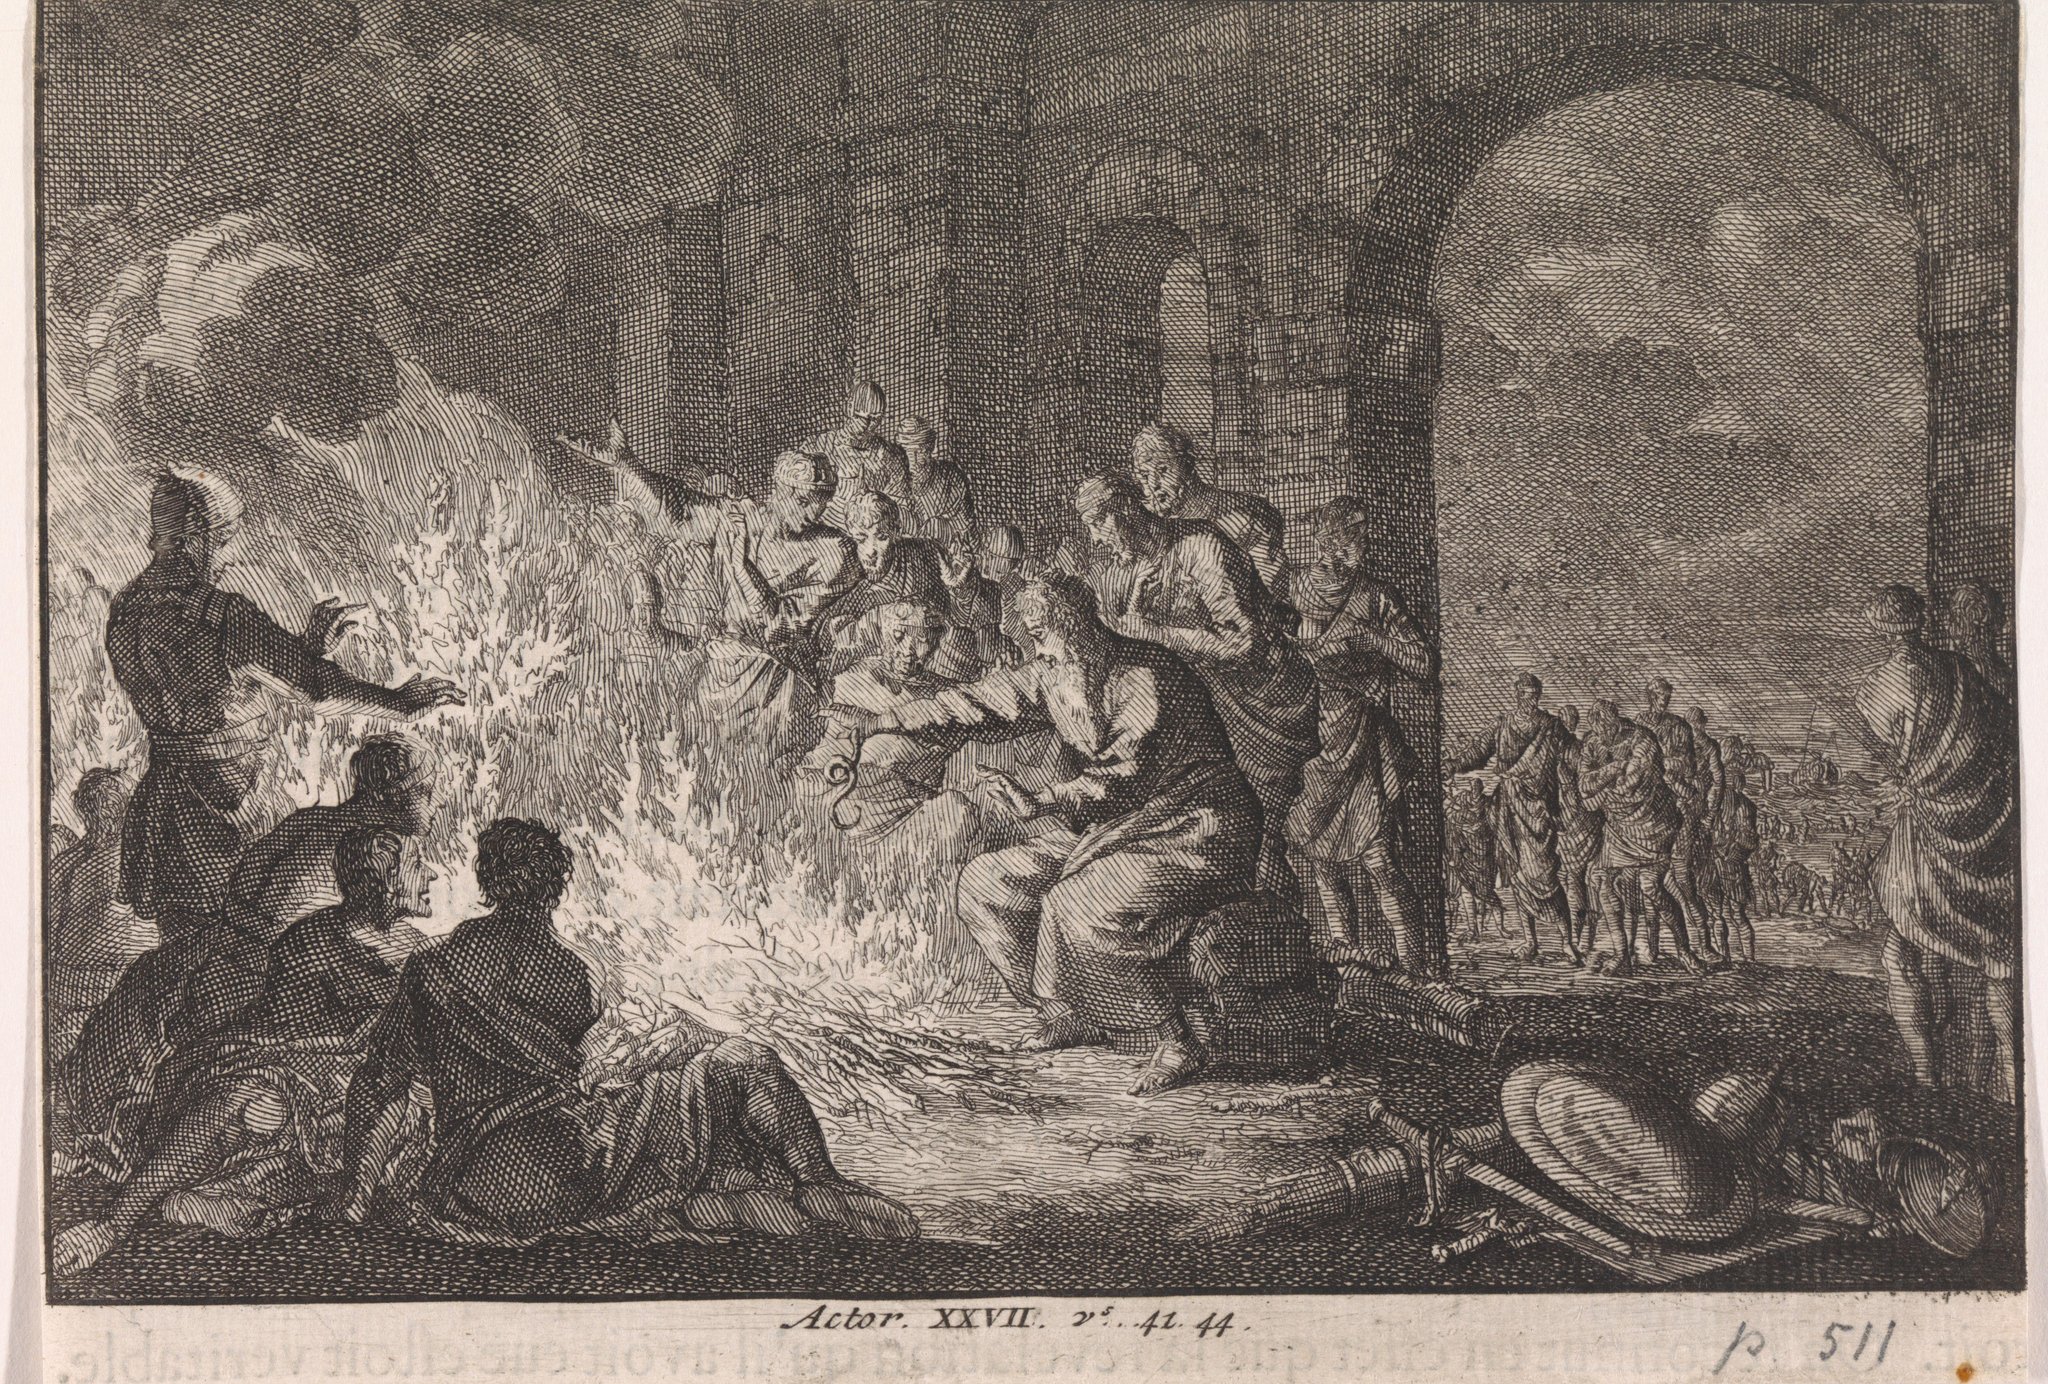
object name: print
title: Paulus wordt in Malta gebeten door een adder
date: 1703-1762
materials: paper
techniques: etching, letterpress printing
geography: amsterdam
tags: paul bitten by a viper (when throwing wood on the fire)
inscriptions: collector's mark: Lugt 2228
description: De prent komt een eerste keer voor als boekillustratie voor David Martin. Historie des Ouden en Nieuwen Testaments. Amsterdam, Pieter Mortier, 1703. Deel II. De boekillustraties voor de Mortierbijbel hebben verschillende staten en kopieën, waarbij de chronologische volgorde moeilijk te achterhalen valt. Als boekillustraties werden ze bovendien herhaaldelijk opnieuw gebruikt voor andere boekwerken.